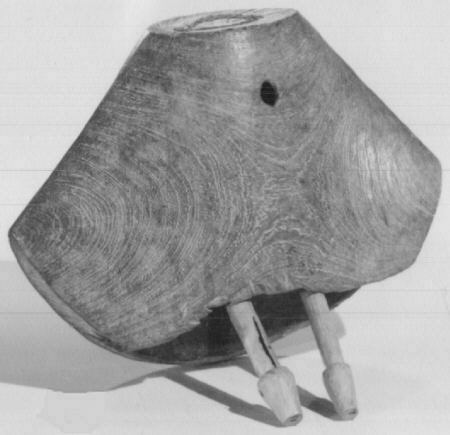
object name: ngonge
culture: congolese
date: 1867-1900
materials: wood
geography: democratic republic of the congo